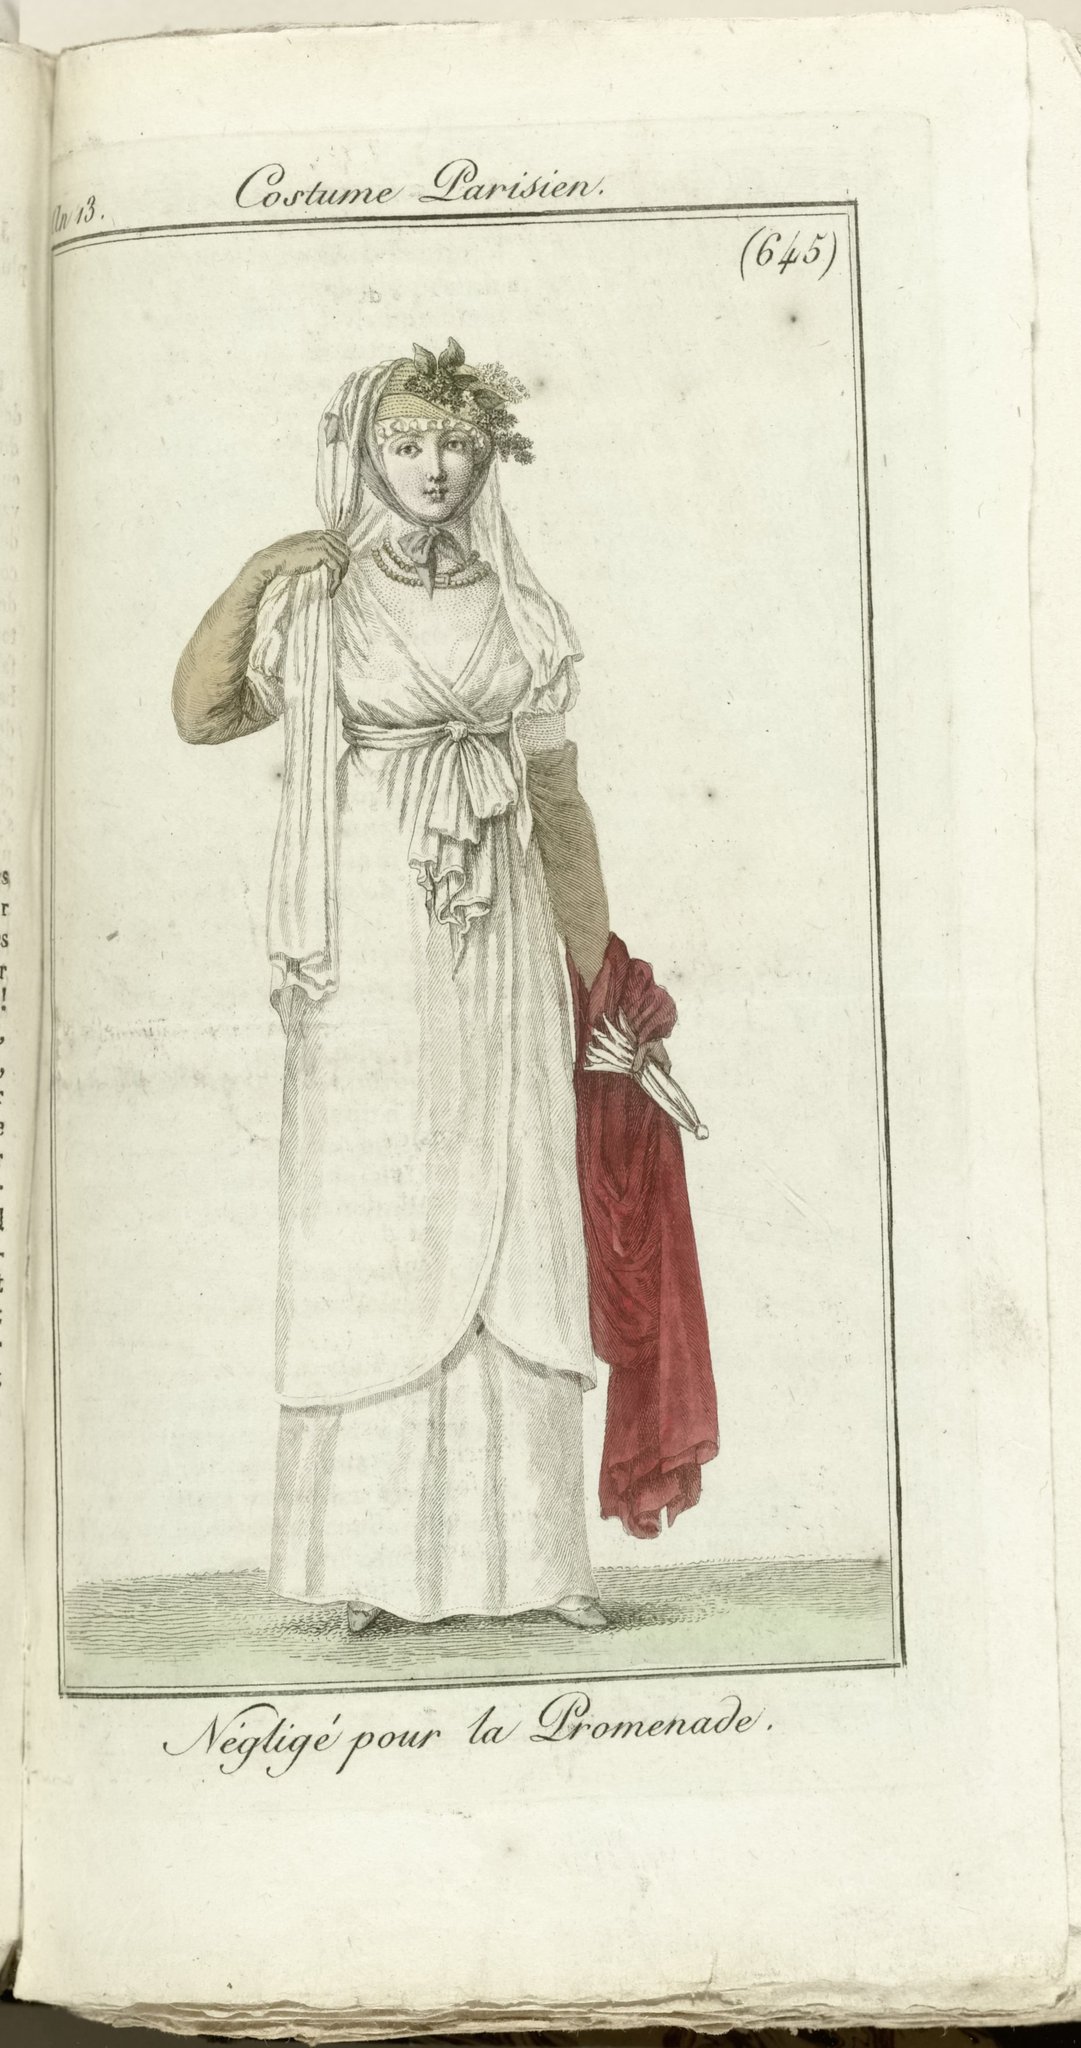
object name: fashion print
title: Journal des Dames et des Modes, Costume Parisien, 1805, An 13 (645) Négligé pour la Promenade.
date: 1805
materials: paper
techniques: engraving, hand coloring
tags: gloves, mittens (long gloves) (+ women's clothes), veil (+ women's clothes), dress, gown: walking dress (+ women's clothes), neck-gear ~ clothing (shawl) (+ women's clothes), head-gear: cap (+ women's clothes), fashion plates, fan (+ women's clothes), pearl; pearl necklace (+ women's clothes)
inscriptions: title: ‘Négligé pour la Promenade.’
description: Vrouw in wandelkostuum bestaande uit een witte japon waarover een los overkleed met V-hals, in de (hoge) taille bijeengehouden met een geknoopt lint. Lange handschoenen. Kapje met bloemen waarover een witte sluier. Lange rode sjaal en gevouwen waaier in de hand